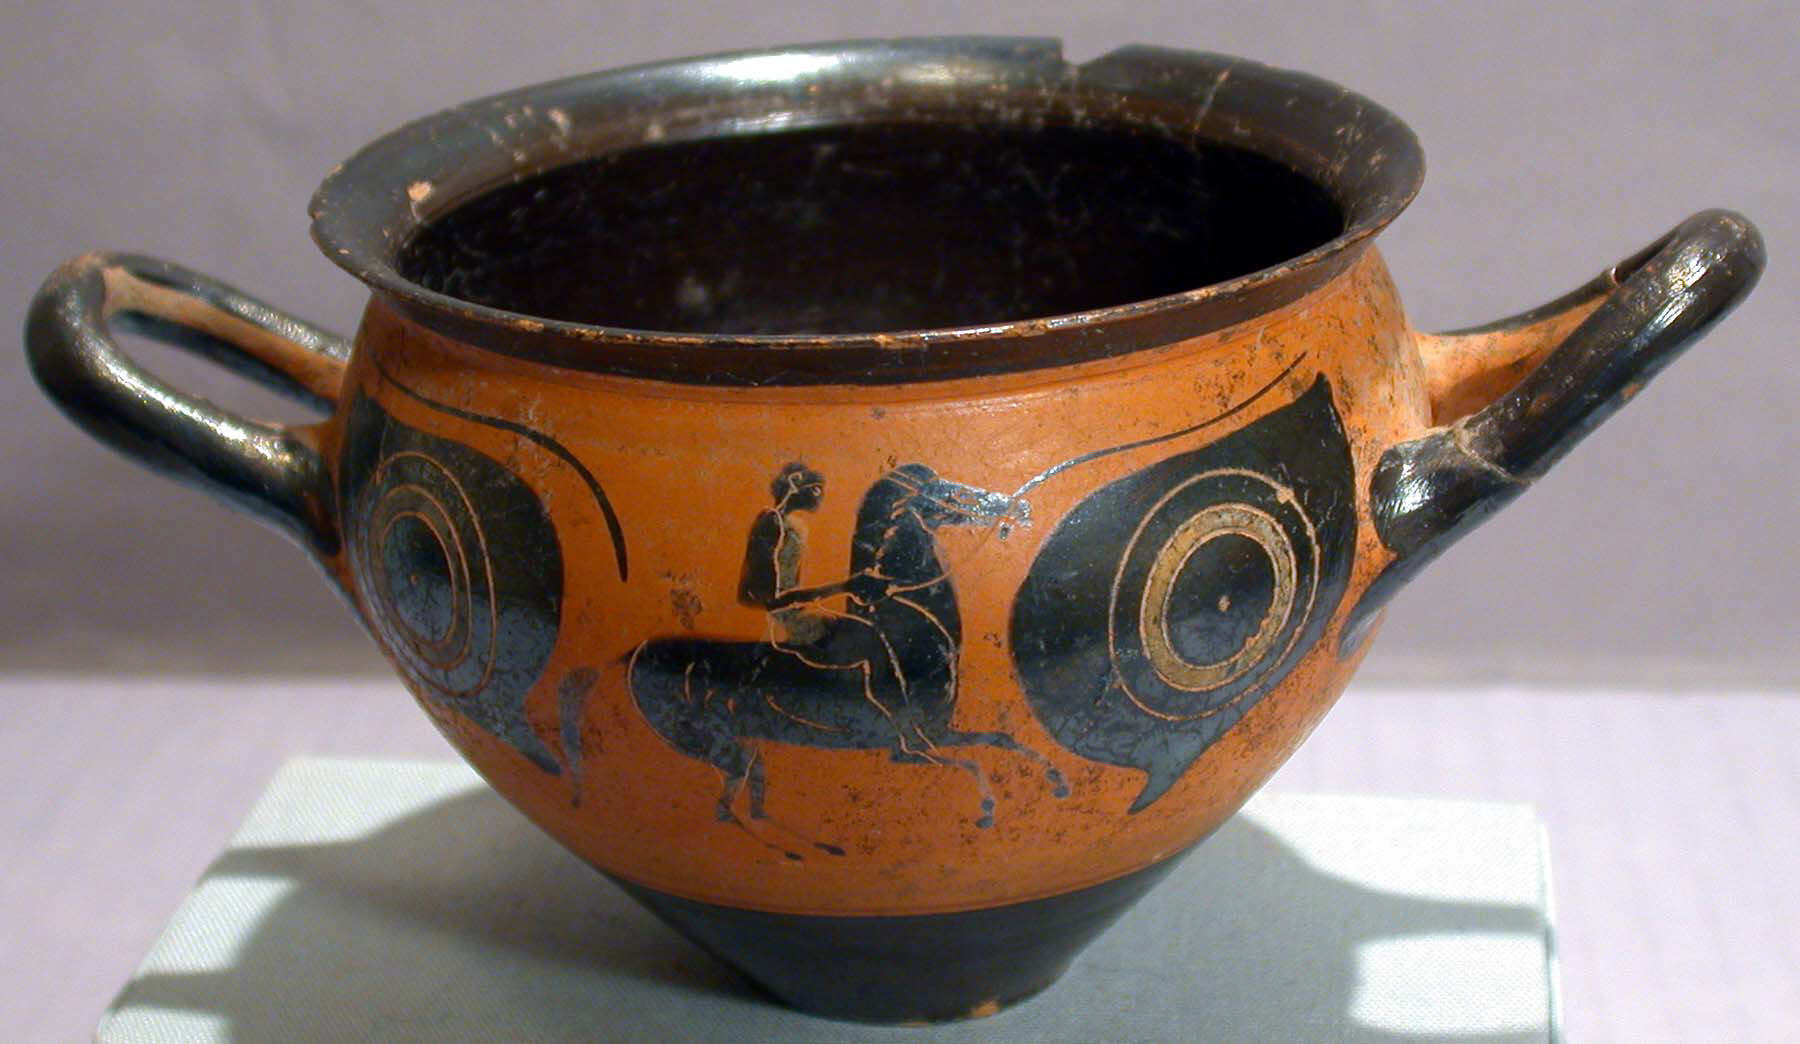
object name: mastoid skyphos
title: Terracotta mastoid skyphos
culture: greek, attic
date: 500 BCE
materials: terracotta